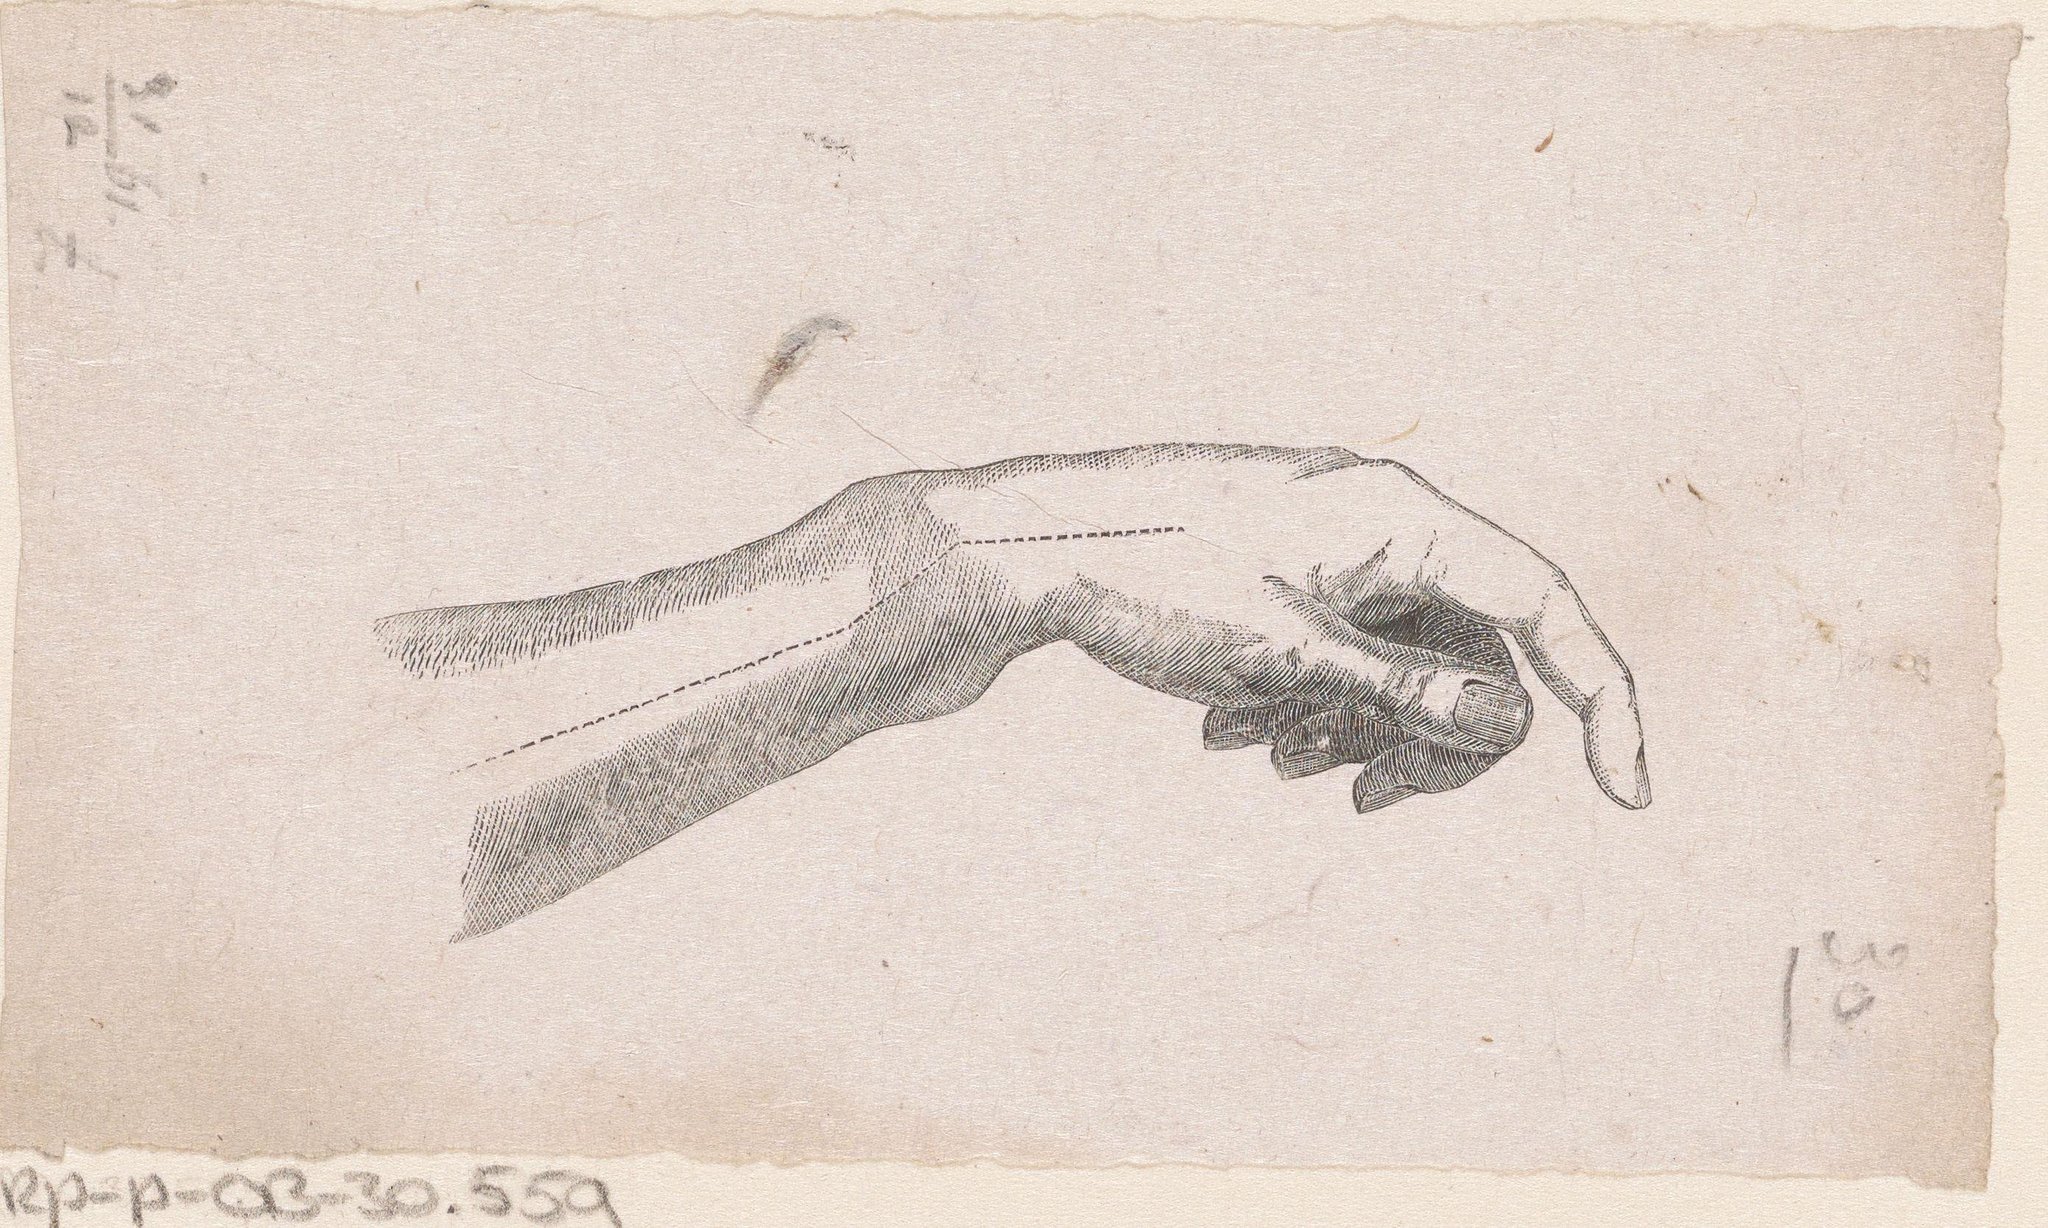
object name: print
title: Menselijke pols met een breuk in het bot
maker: isaac weissenbruch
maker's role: print maker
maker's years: 1826-1912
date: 1836-1912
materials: paper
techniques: engraving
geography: netherlands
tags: carpus and metacarpus, parts of the hand, fractures of bones